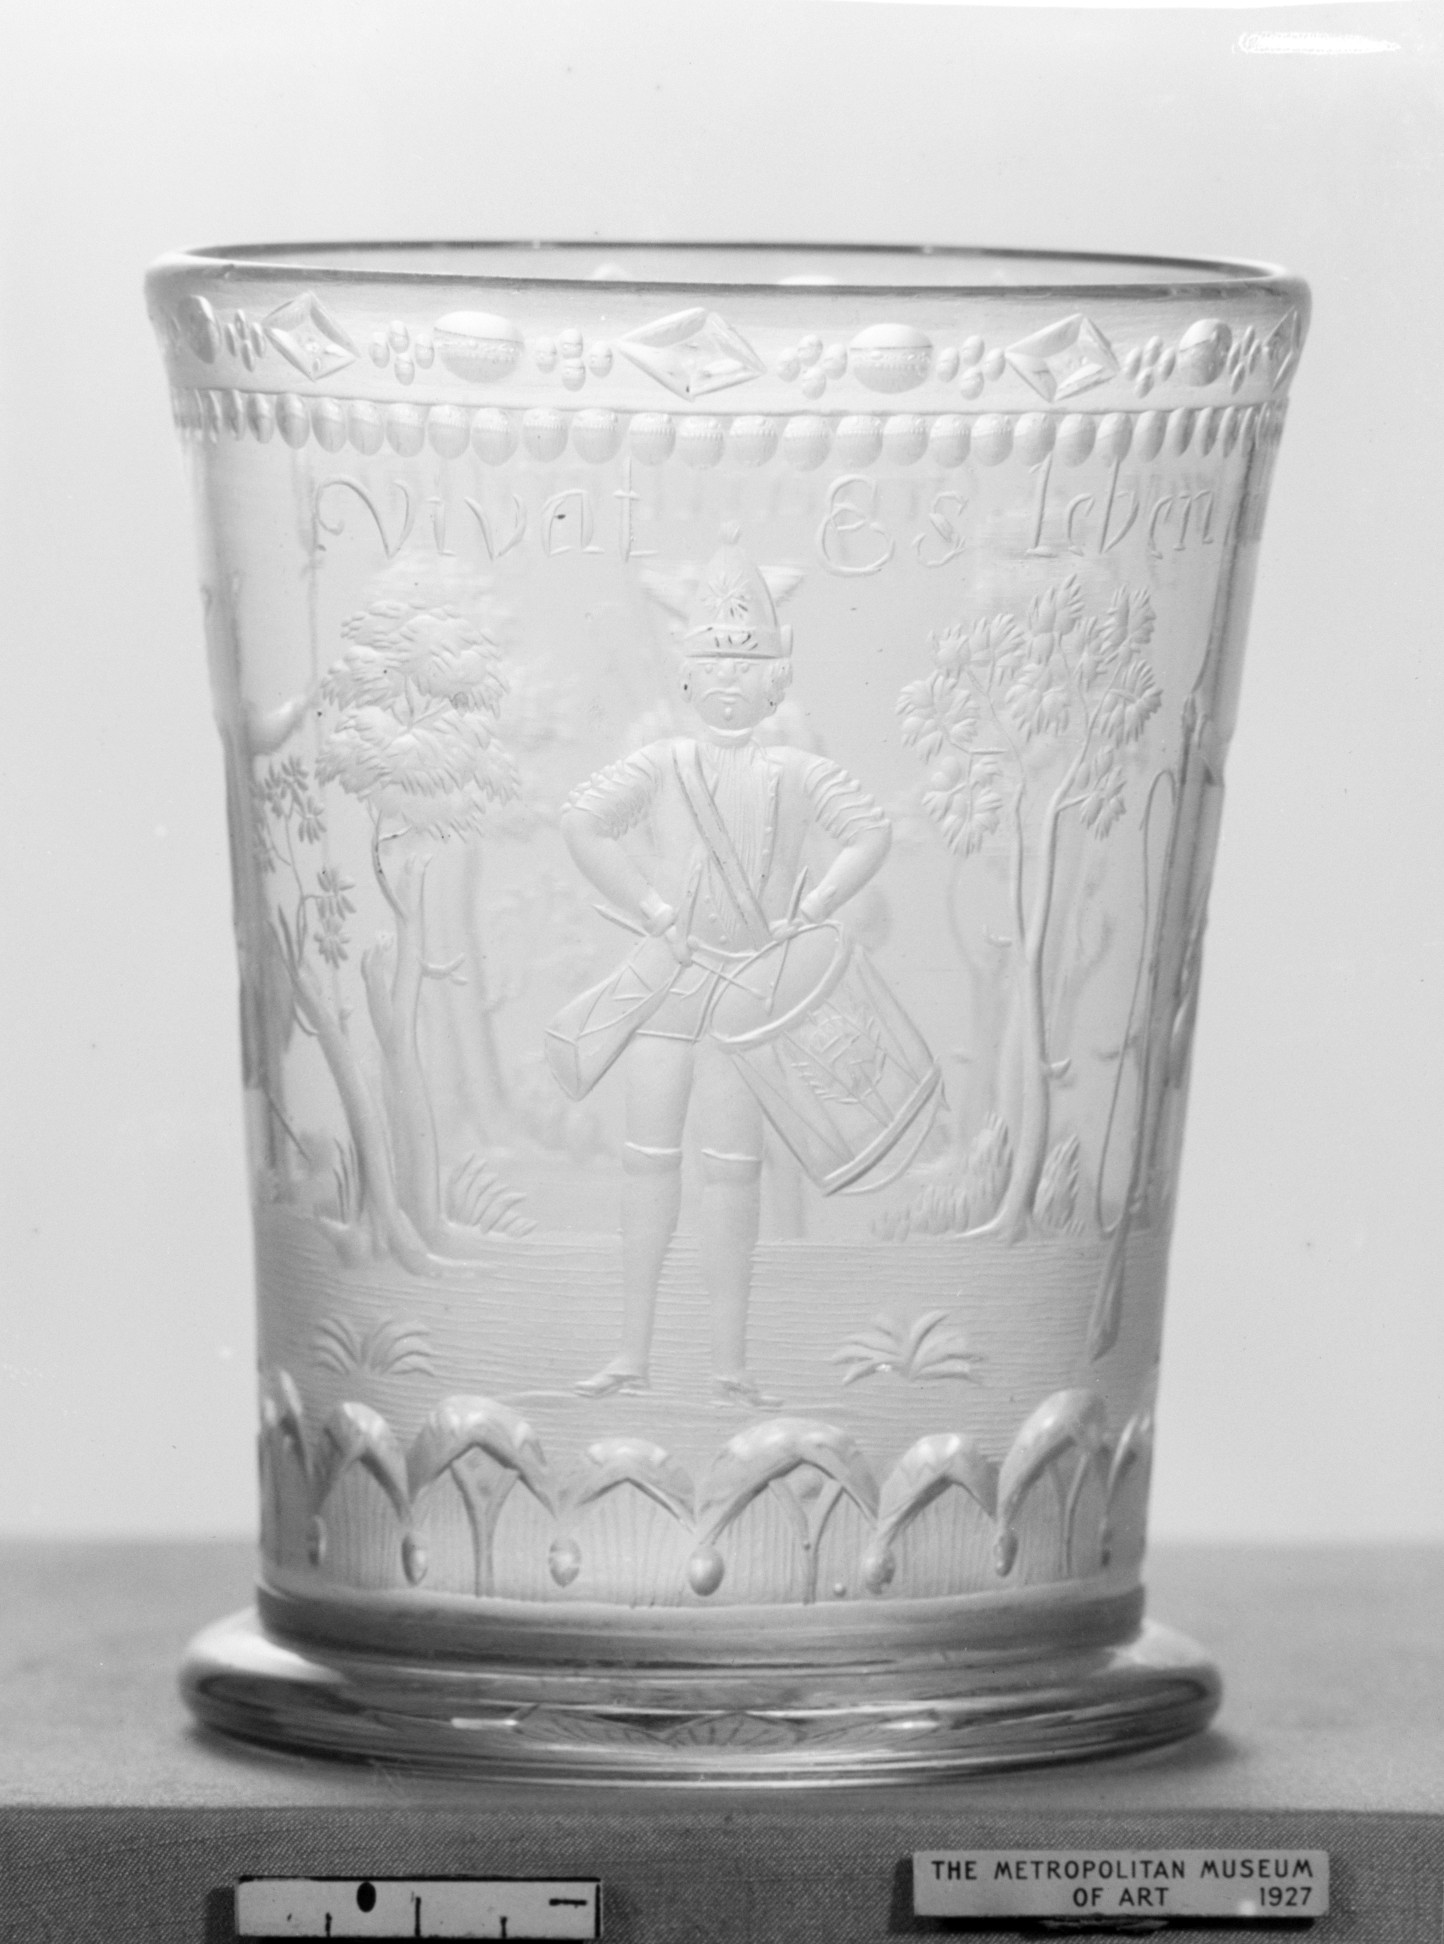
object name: beaker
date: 1710-1720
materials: glass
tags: soldiers,men